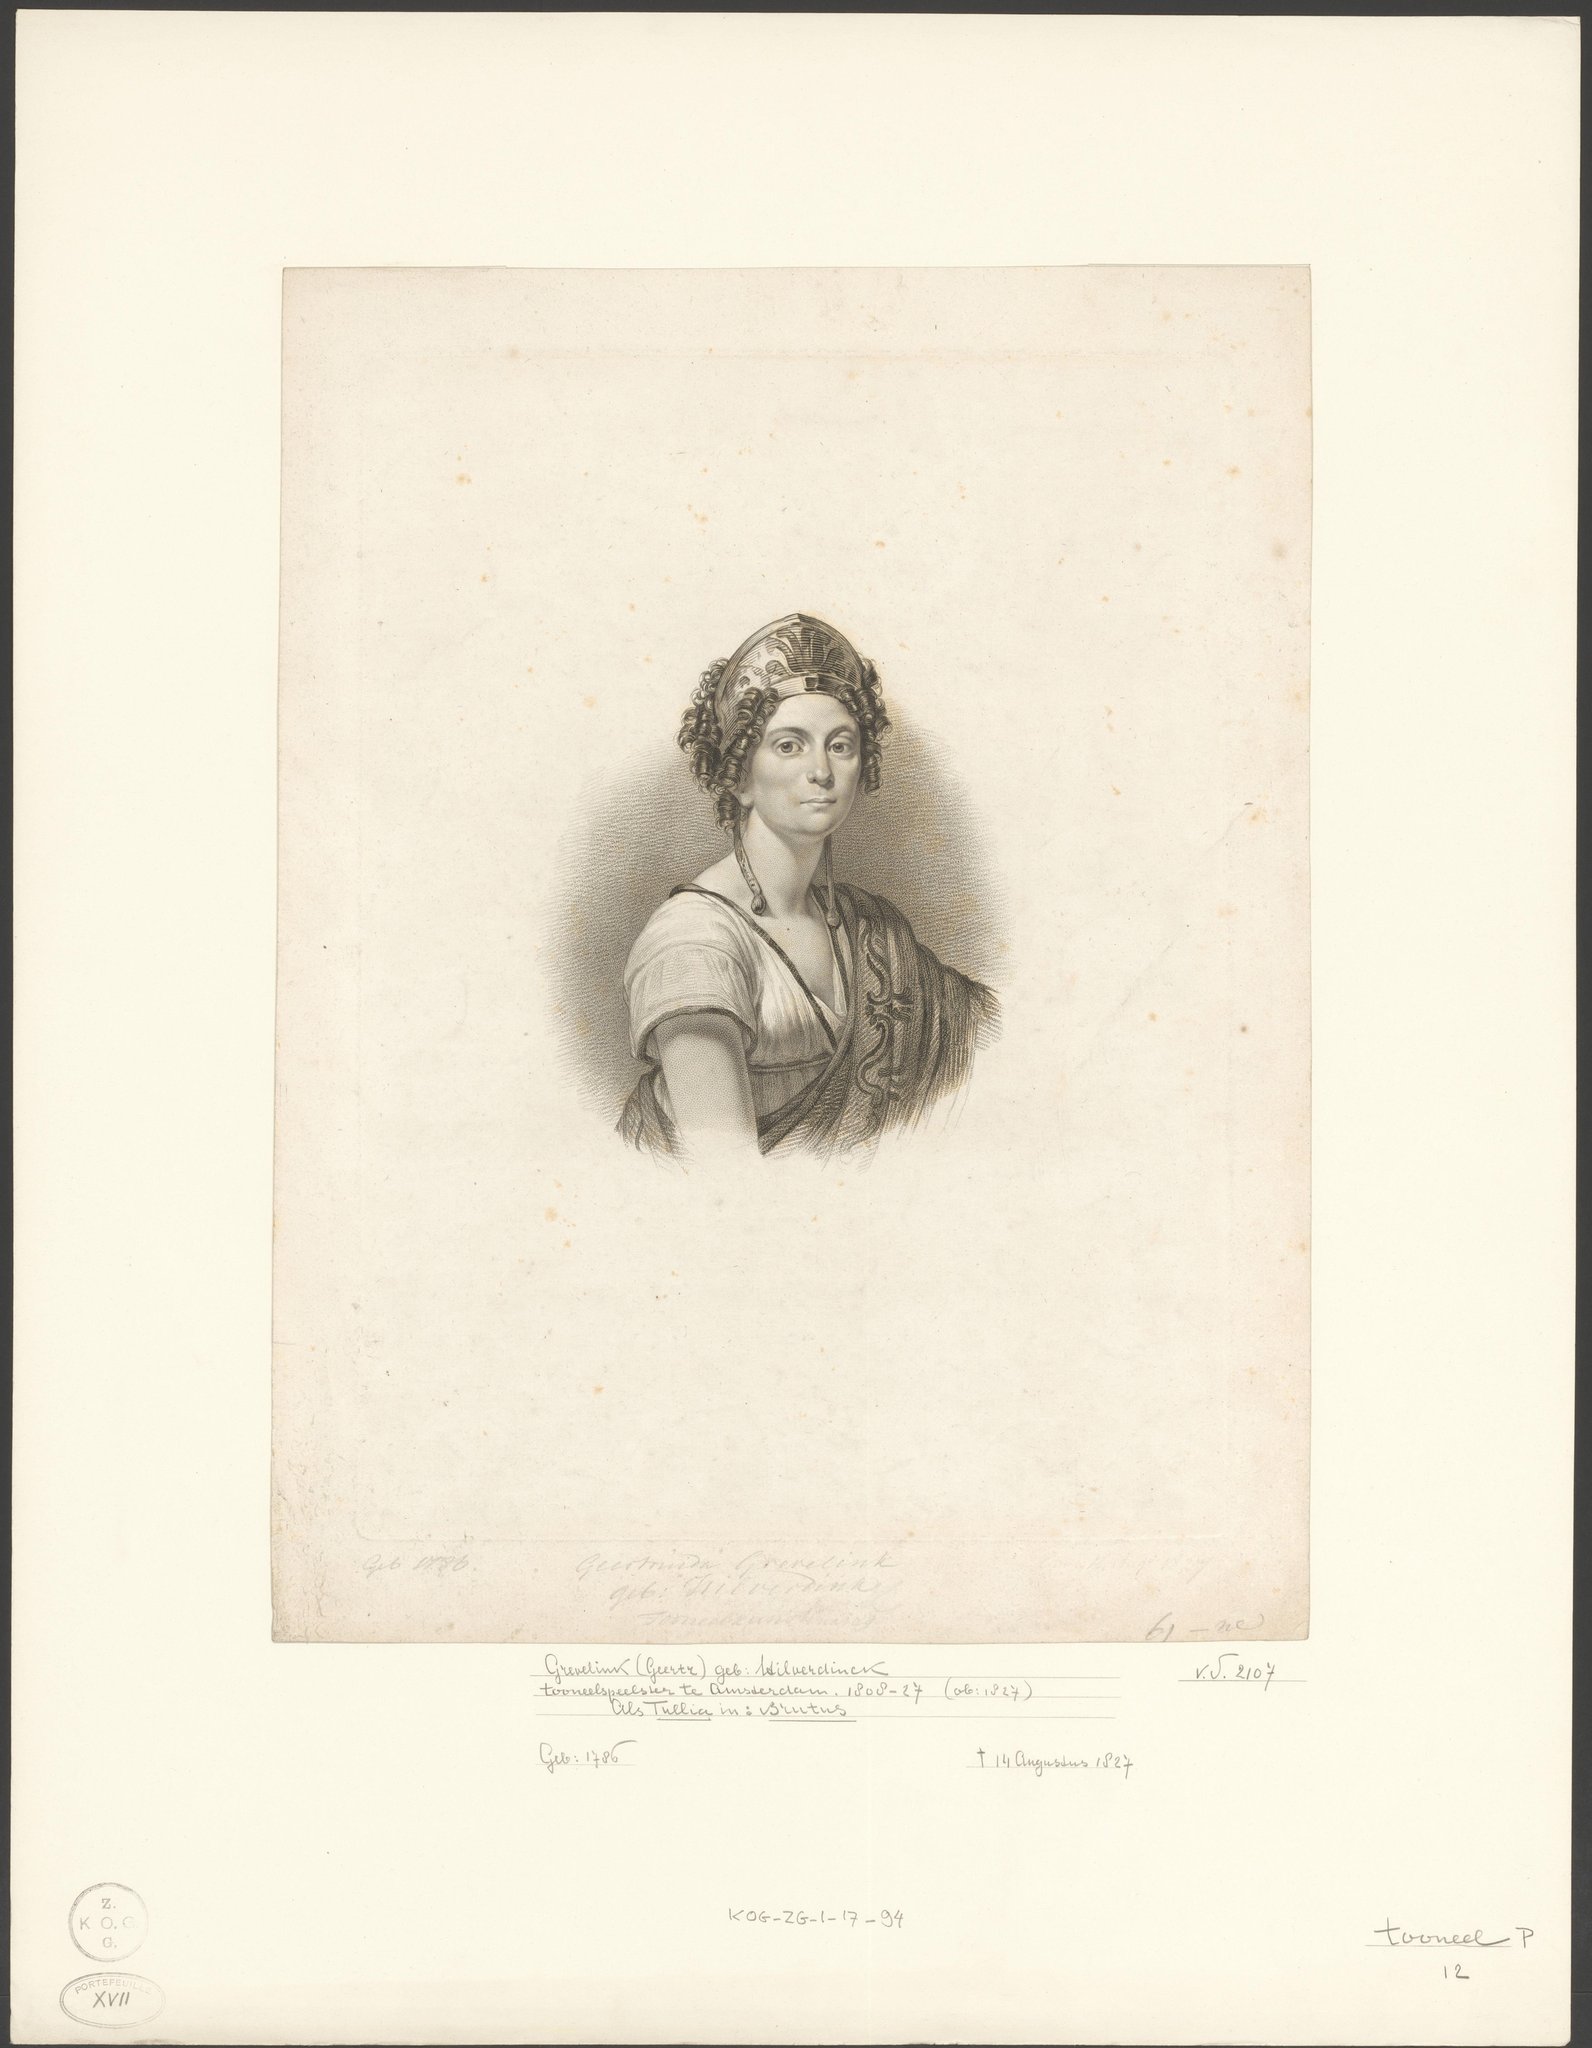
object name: print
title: Portret van Geertruida Jacoba Hilverdink als Tullia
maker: Anonymous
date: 1827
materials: paper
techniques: etching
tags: geertruida jacoba hilverdink, stage costume, historical persons - bb - woman, actor (on the stage)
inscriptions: stamp, collector's mark: Lugt 1641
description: Geertruida Jacoba Hilverdink als Tullia in Brutus. Op 8 mei 1827 speelde zij deze rol, het was het laatste stuk dat zij speelde voor zij overleed. Onderwerpsrubrieken binnen de Atlas Zeden en Gewoonten: Tooneel, Portretten van toneelspelers.